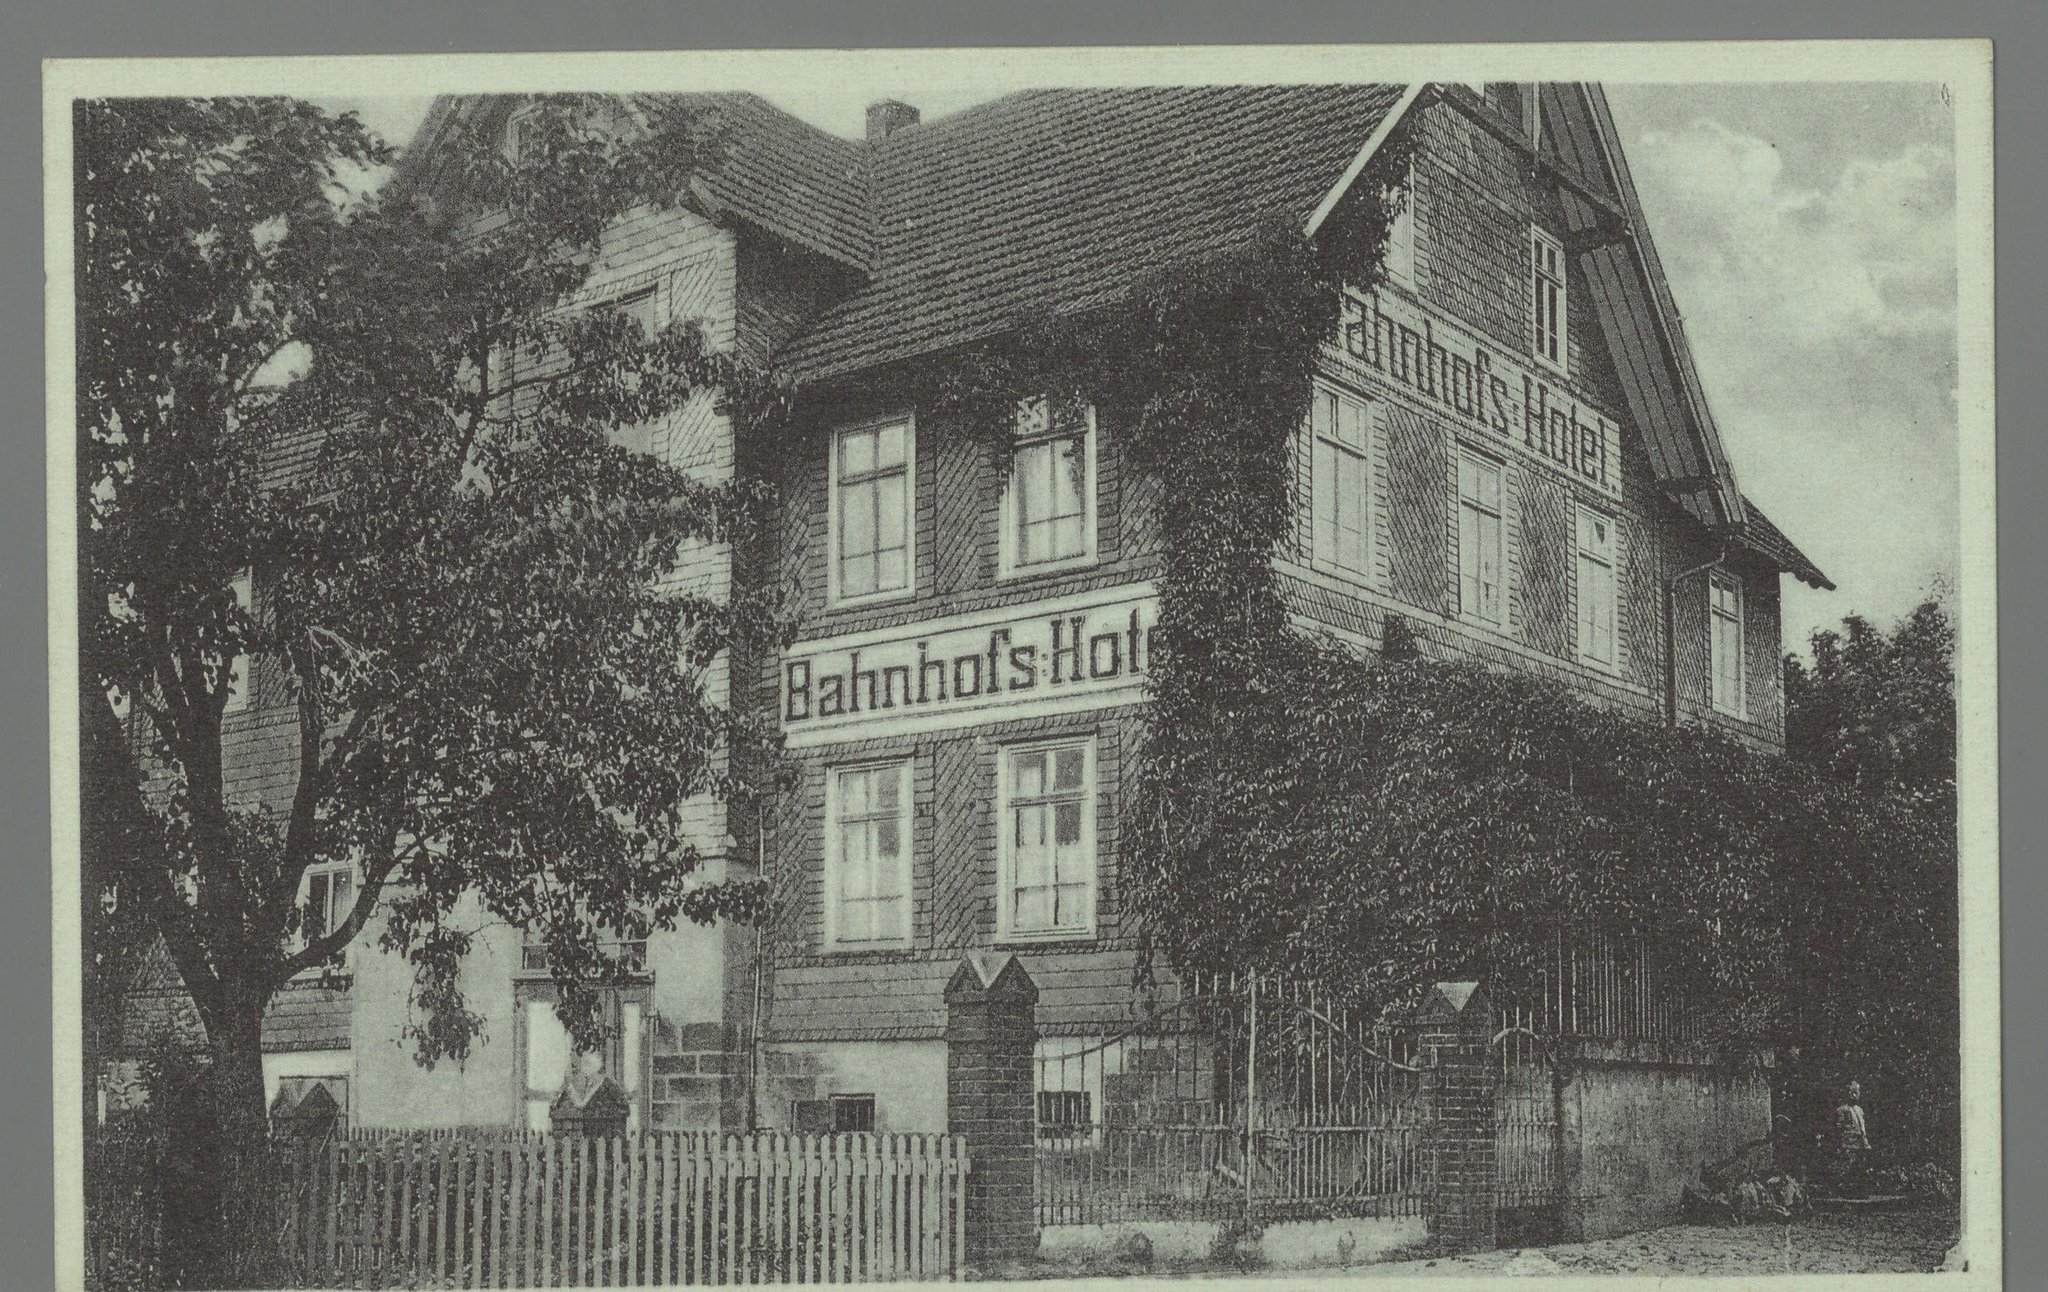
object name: ansichtkaart, prentbriefkaart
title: "Bahnhofs=Hotel" Wetter <Hessen=Nassau>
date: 1905-1927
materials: cardboard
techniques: photograph, writing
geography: wetter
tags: hotel, hostelry, inn